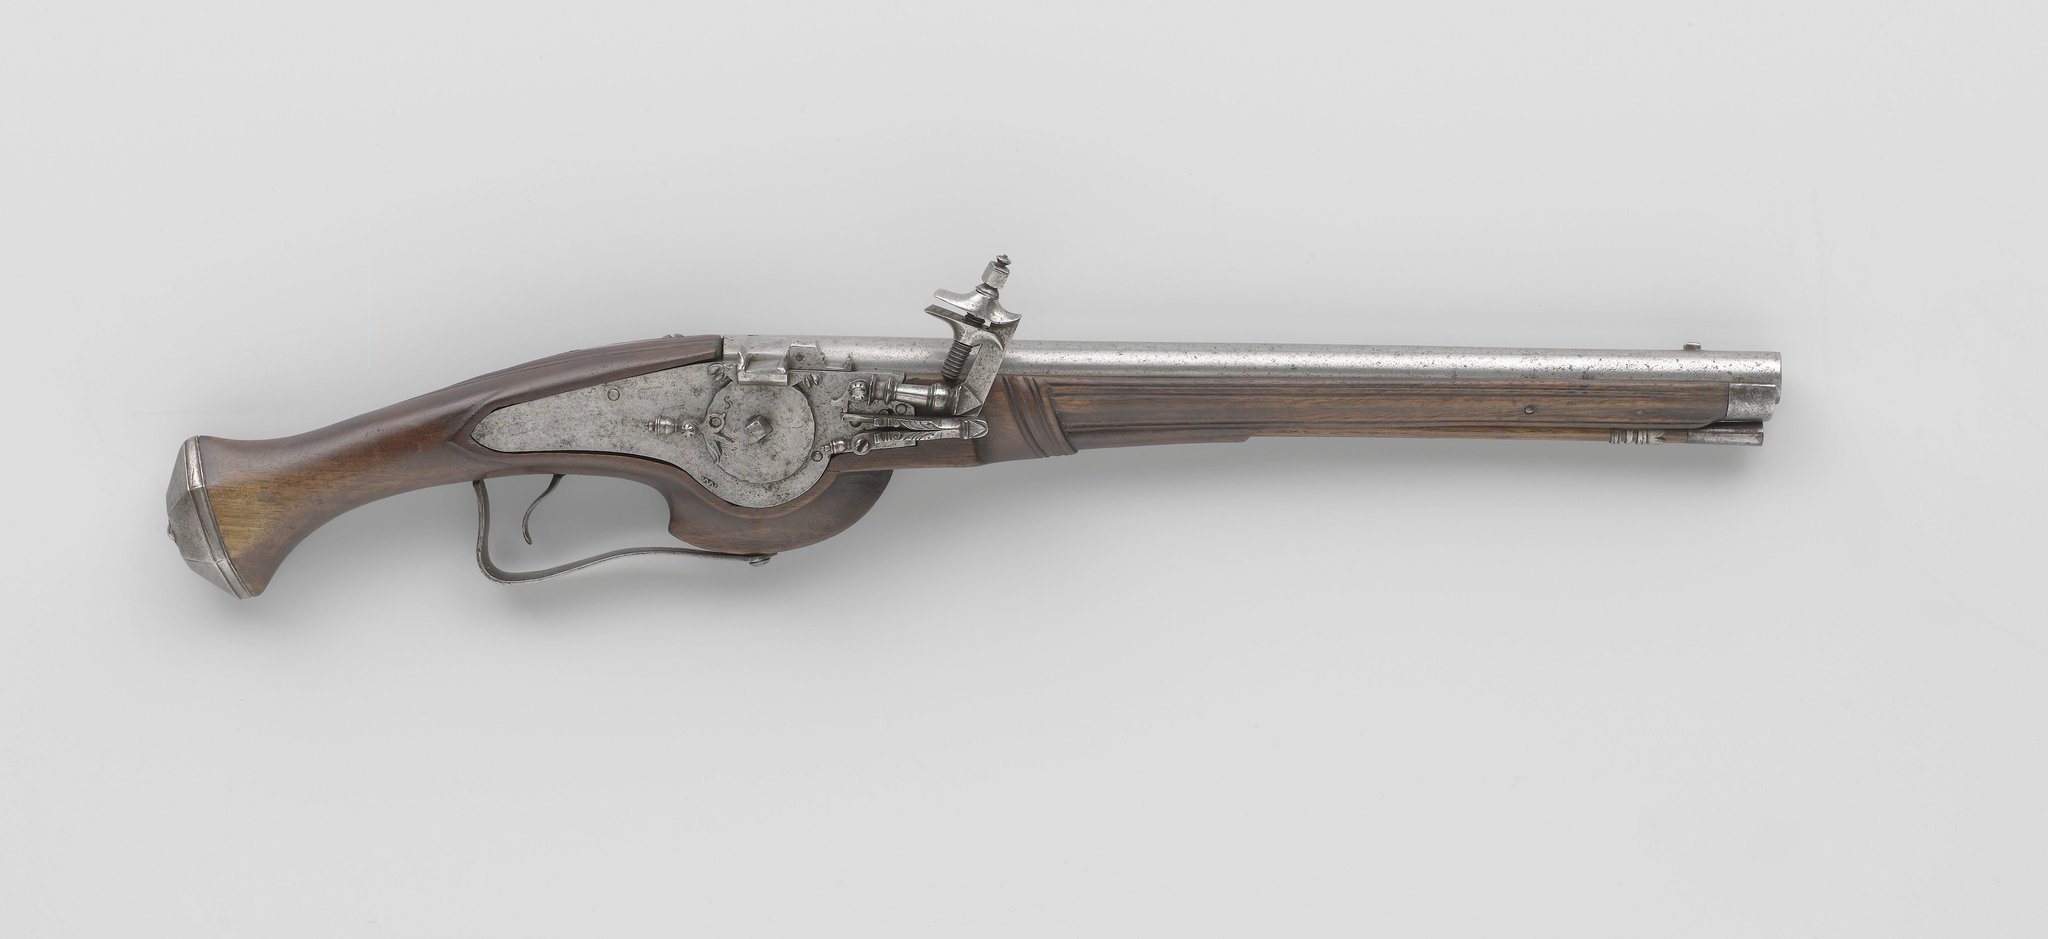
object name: radslotpistool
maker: Anonymous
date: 1620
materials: horn, iron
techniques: printing, cutting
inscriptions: mark